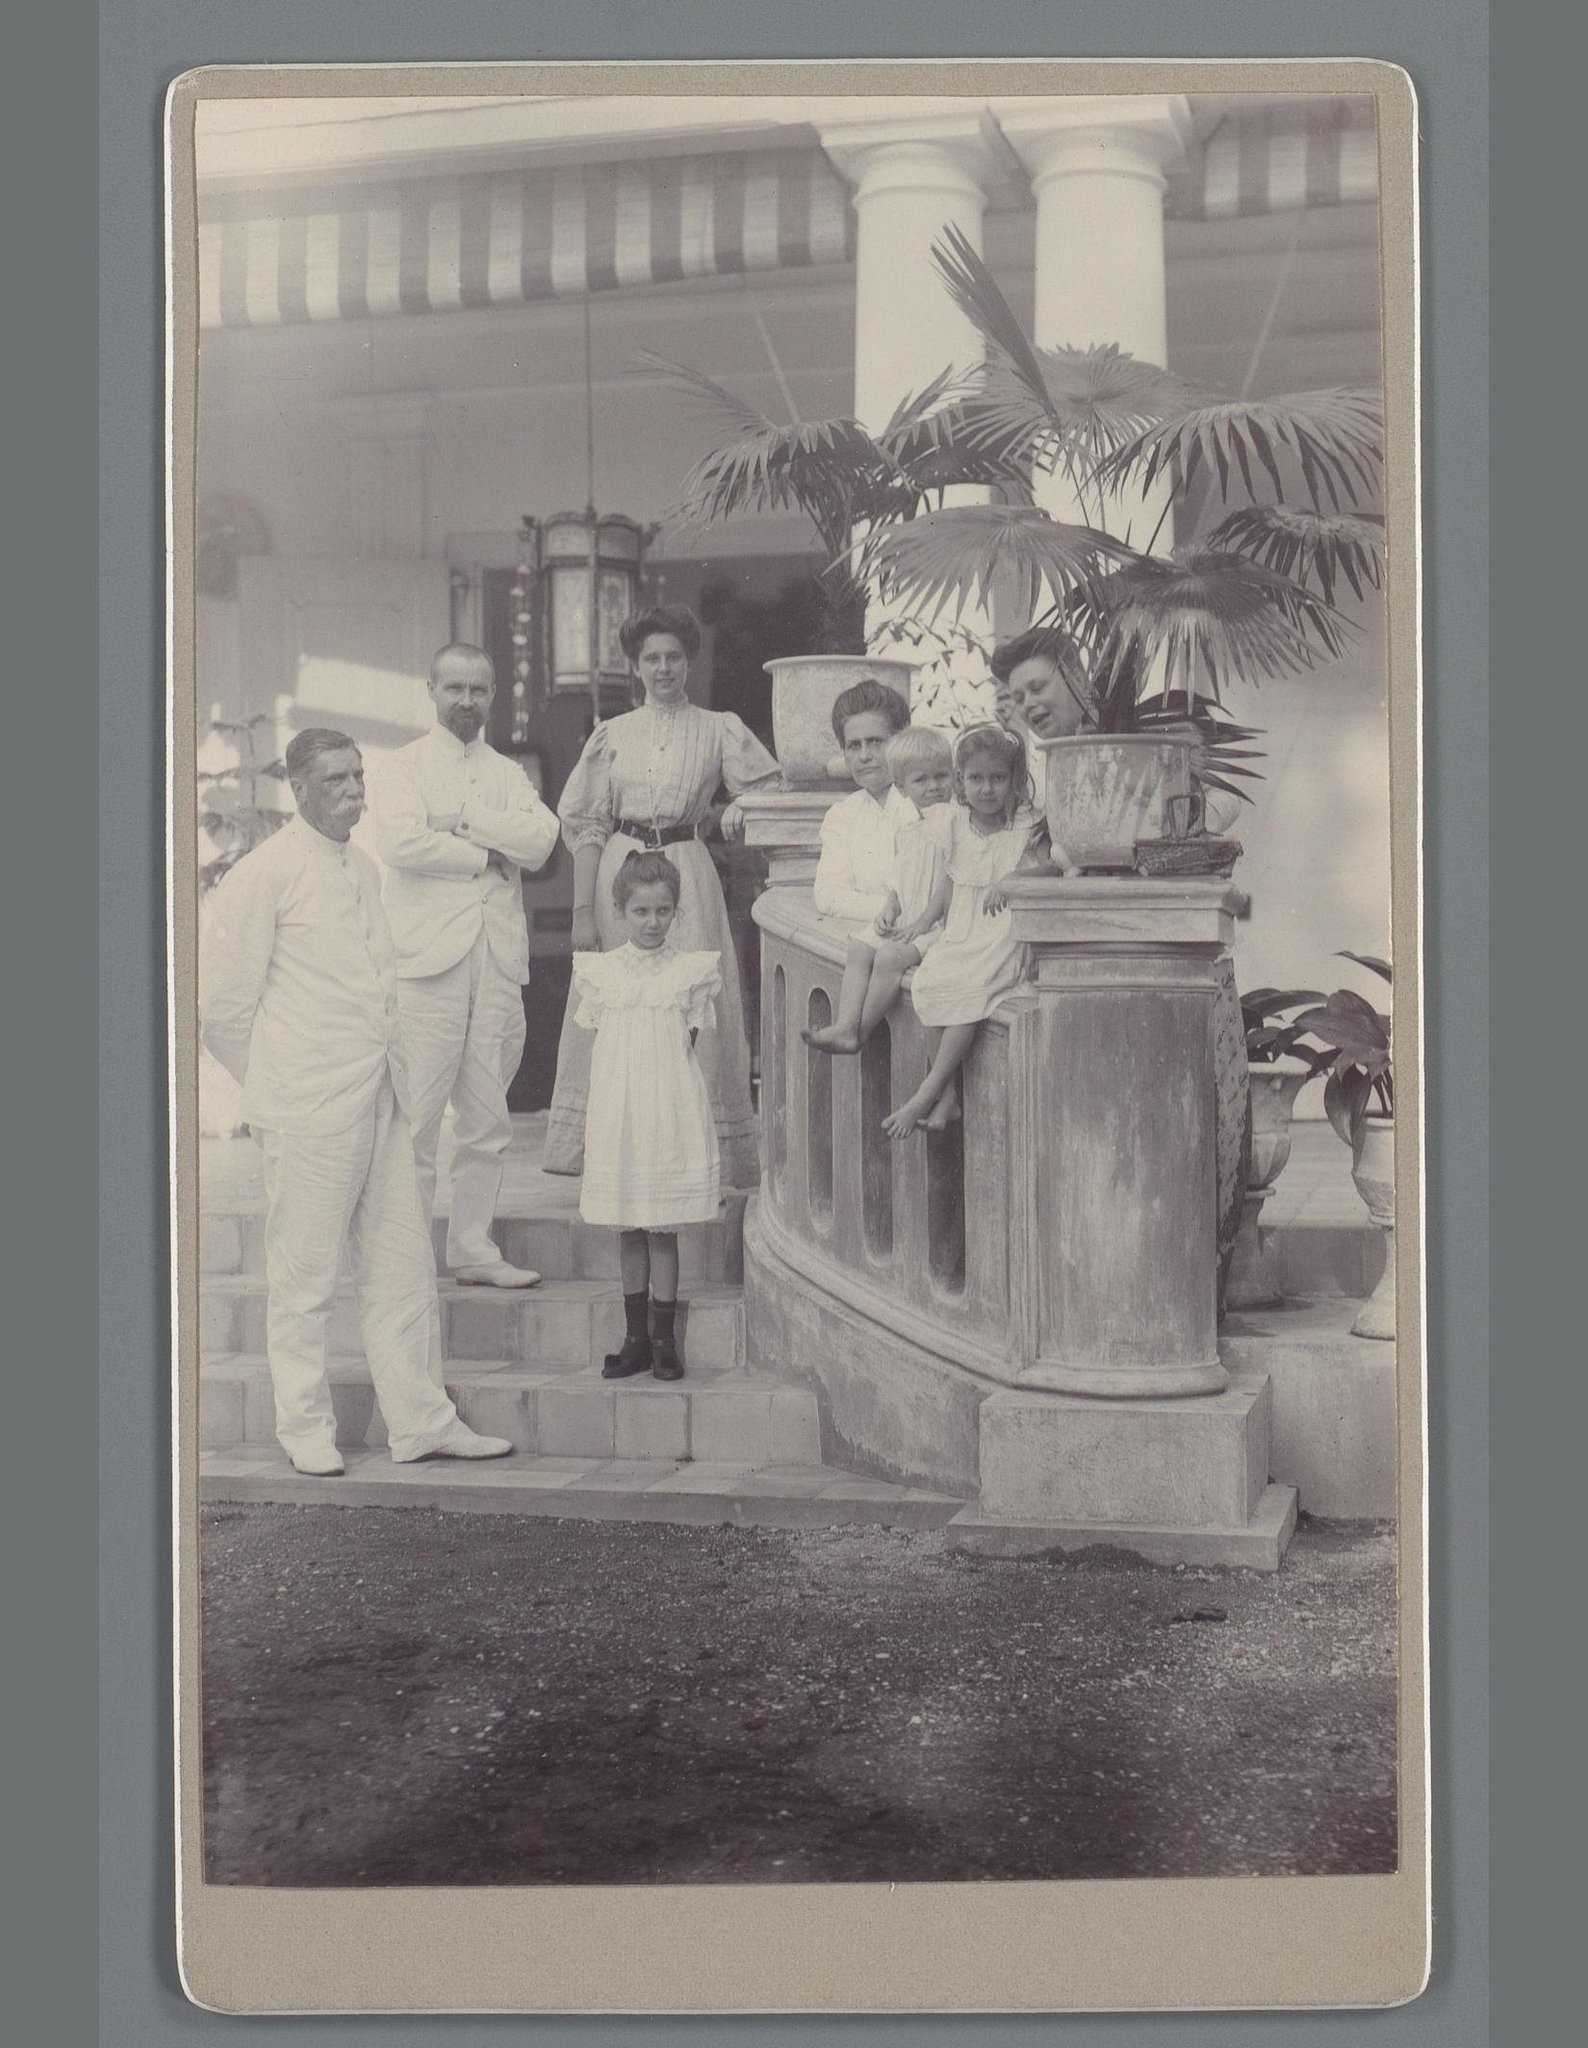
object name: cabinet photograph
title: Groepsportret van onbekende mannen, vrouwen en kinderen op de trap van een veranda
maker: Anonymous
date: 1880-1910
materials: paper, cardboard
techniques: matte daylight collodion silver print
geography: dutch east indies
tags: family group, especially parents with their child(ren), loggia, verandah, porch, anonymous historical persons portrayed in a group, in a group-portrait, dutch east indies, the